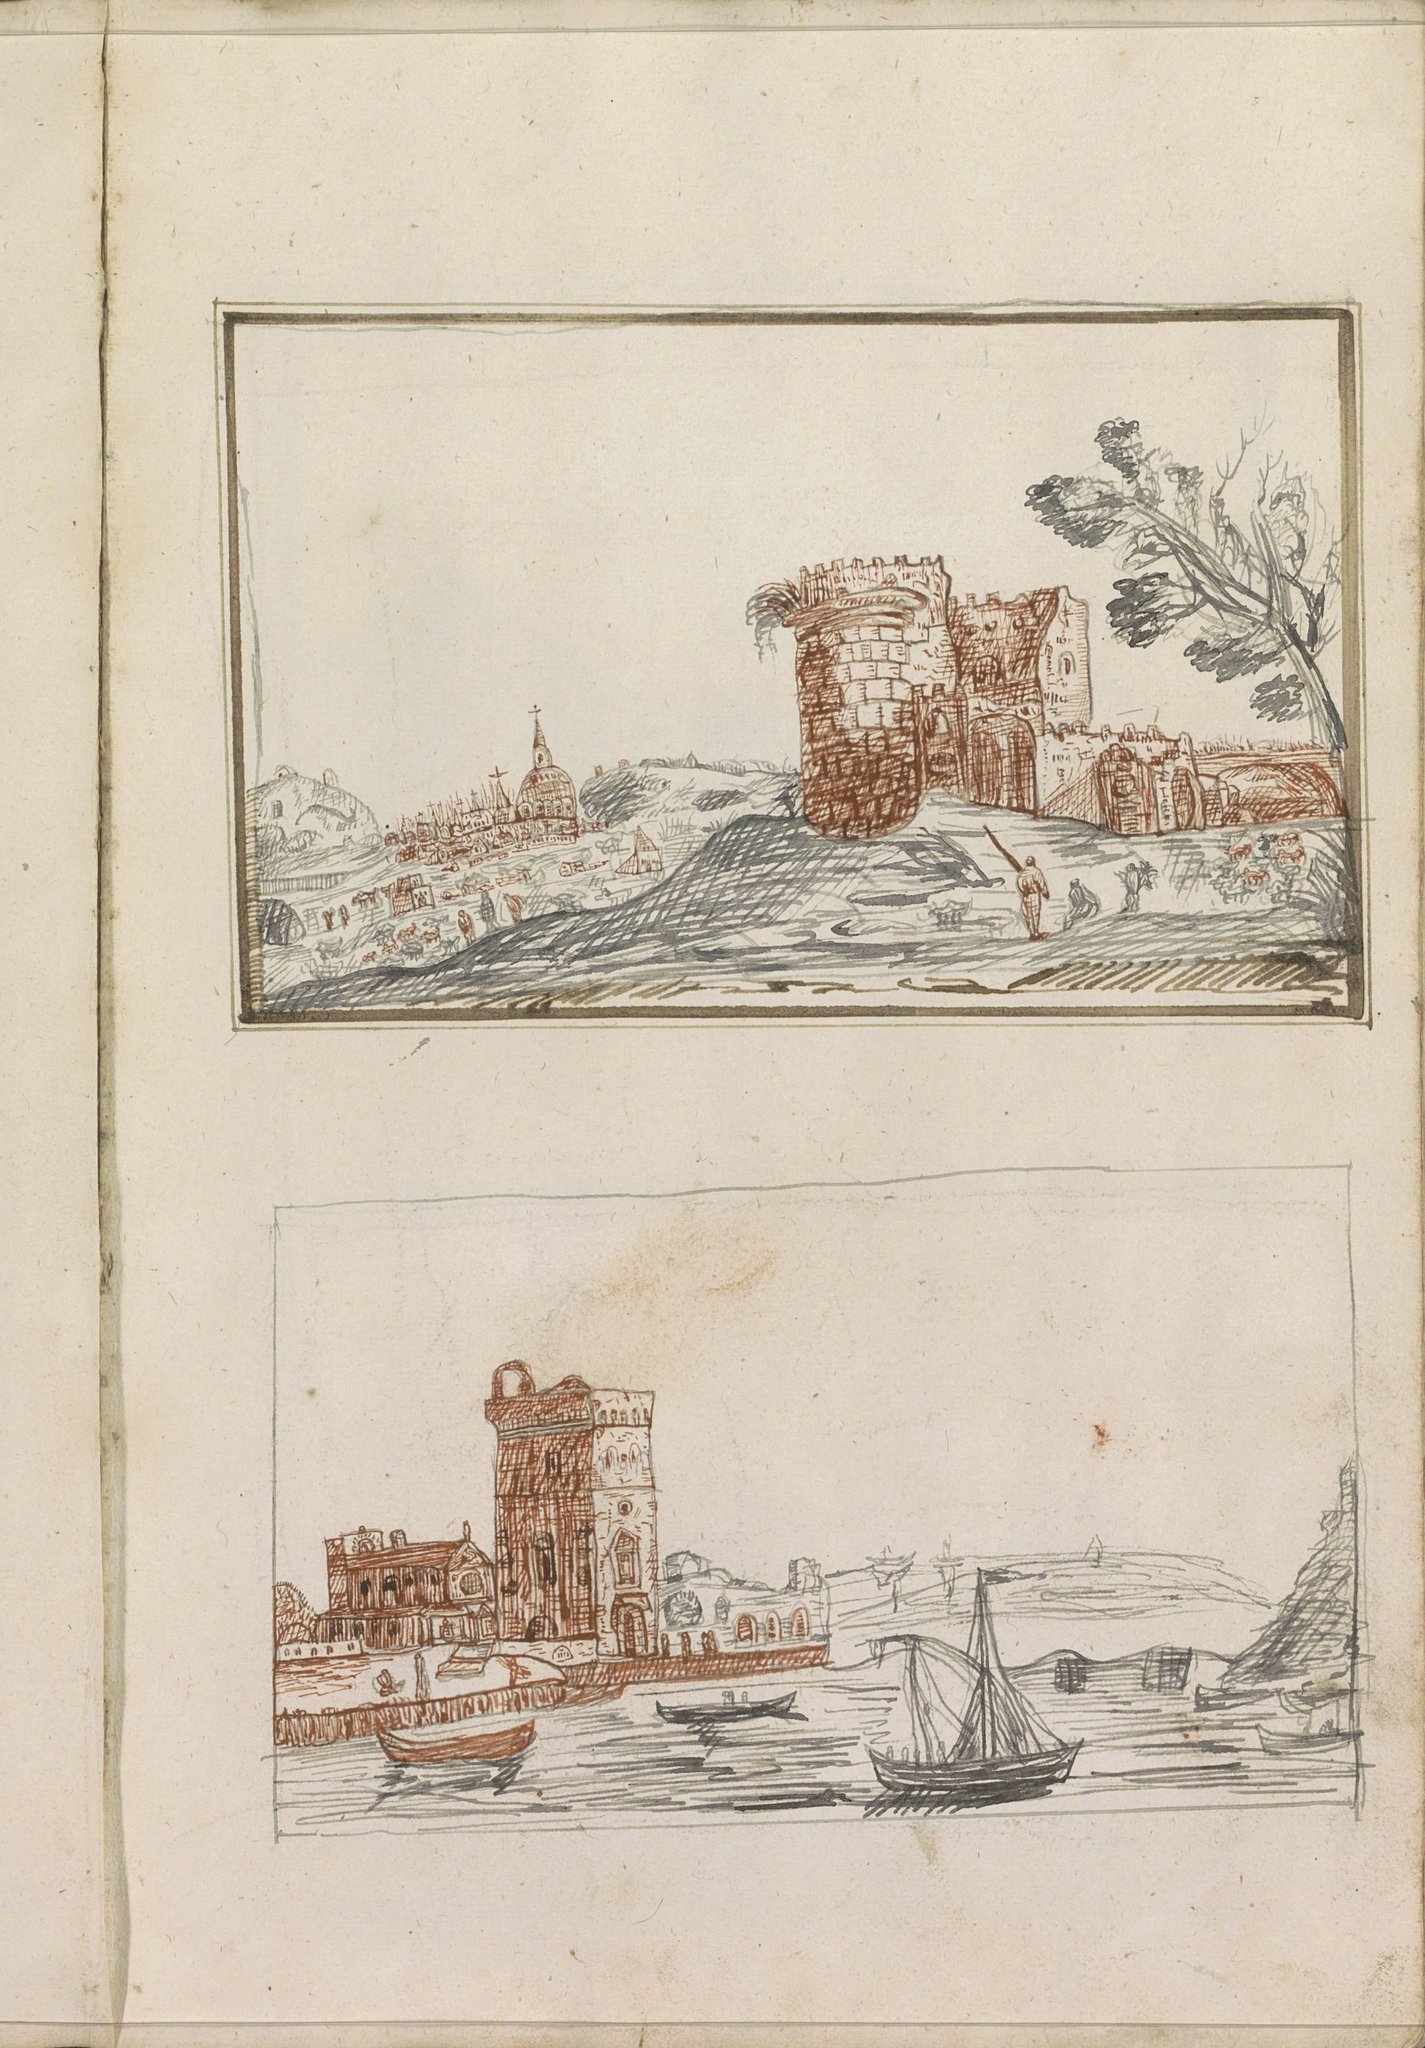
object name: sketchbook leaf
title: Twee stadsgezichten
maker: hendrick van beaumont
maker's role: draughtsman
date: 1696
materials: ink, paper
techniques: pen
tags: city-view, and landscape with man-made constructions, landscapes with waters, waterscapes, seascapes (in the temperate zone), parts of church exterior and annexes: tower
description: Gezicht op een stad met een verdedigingstoren en een gezicht op een stad aan het water. Blad 35 recto uit een schetsboek met 91 bladen.